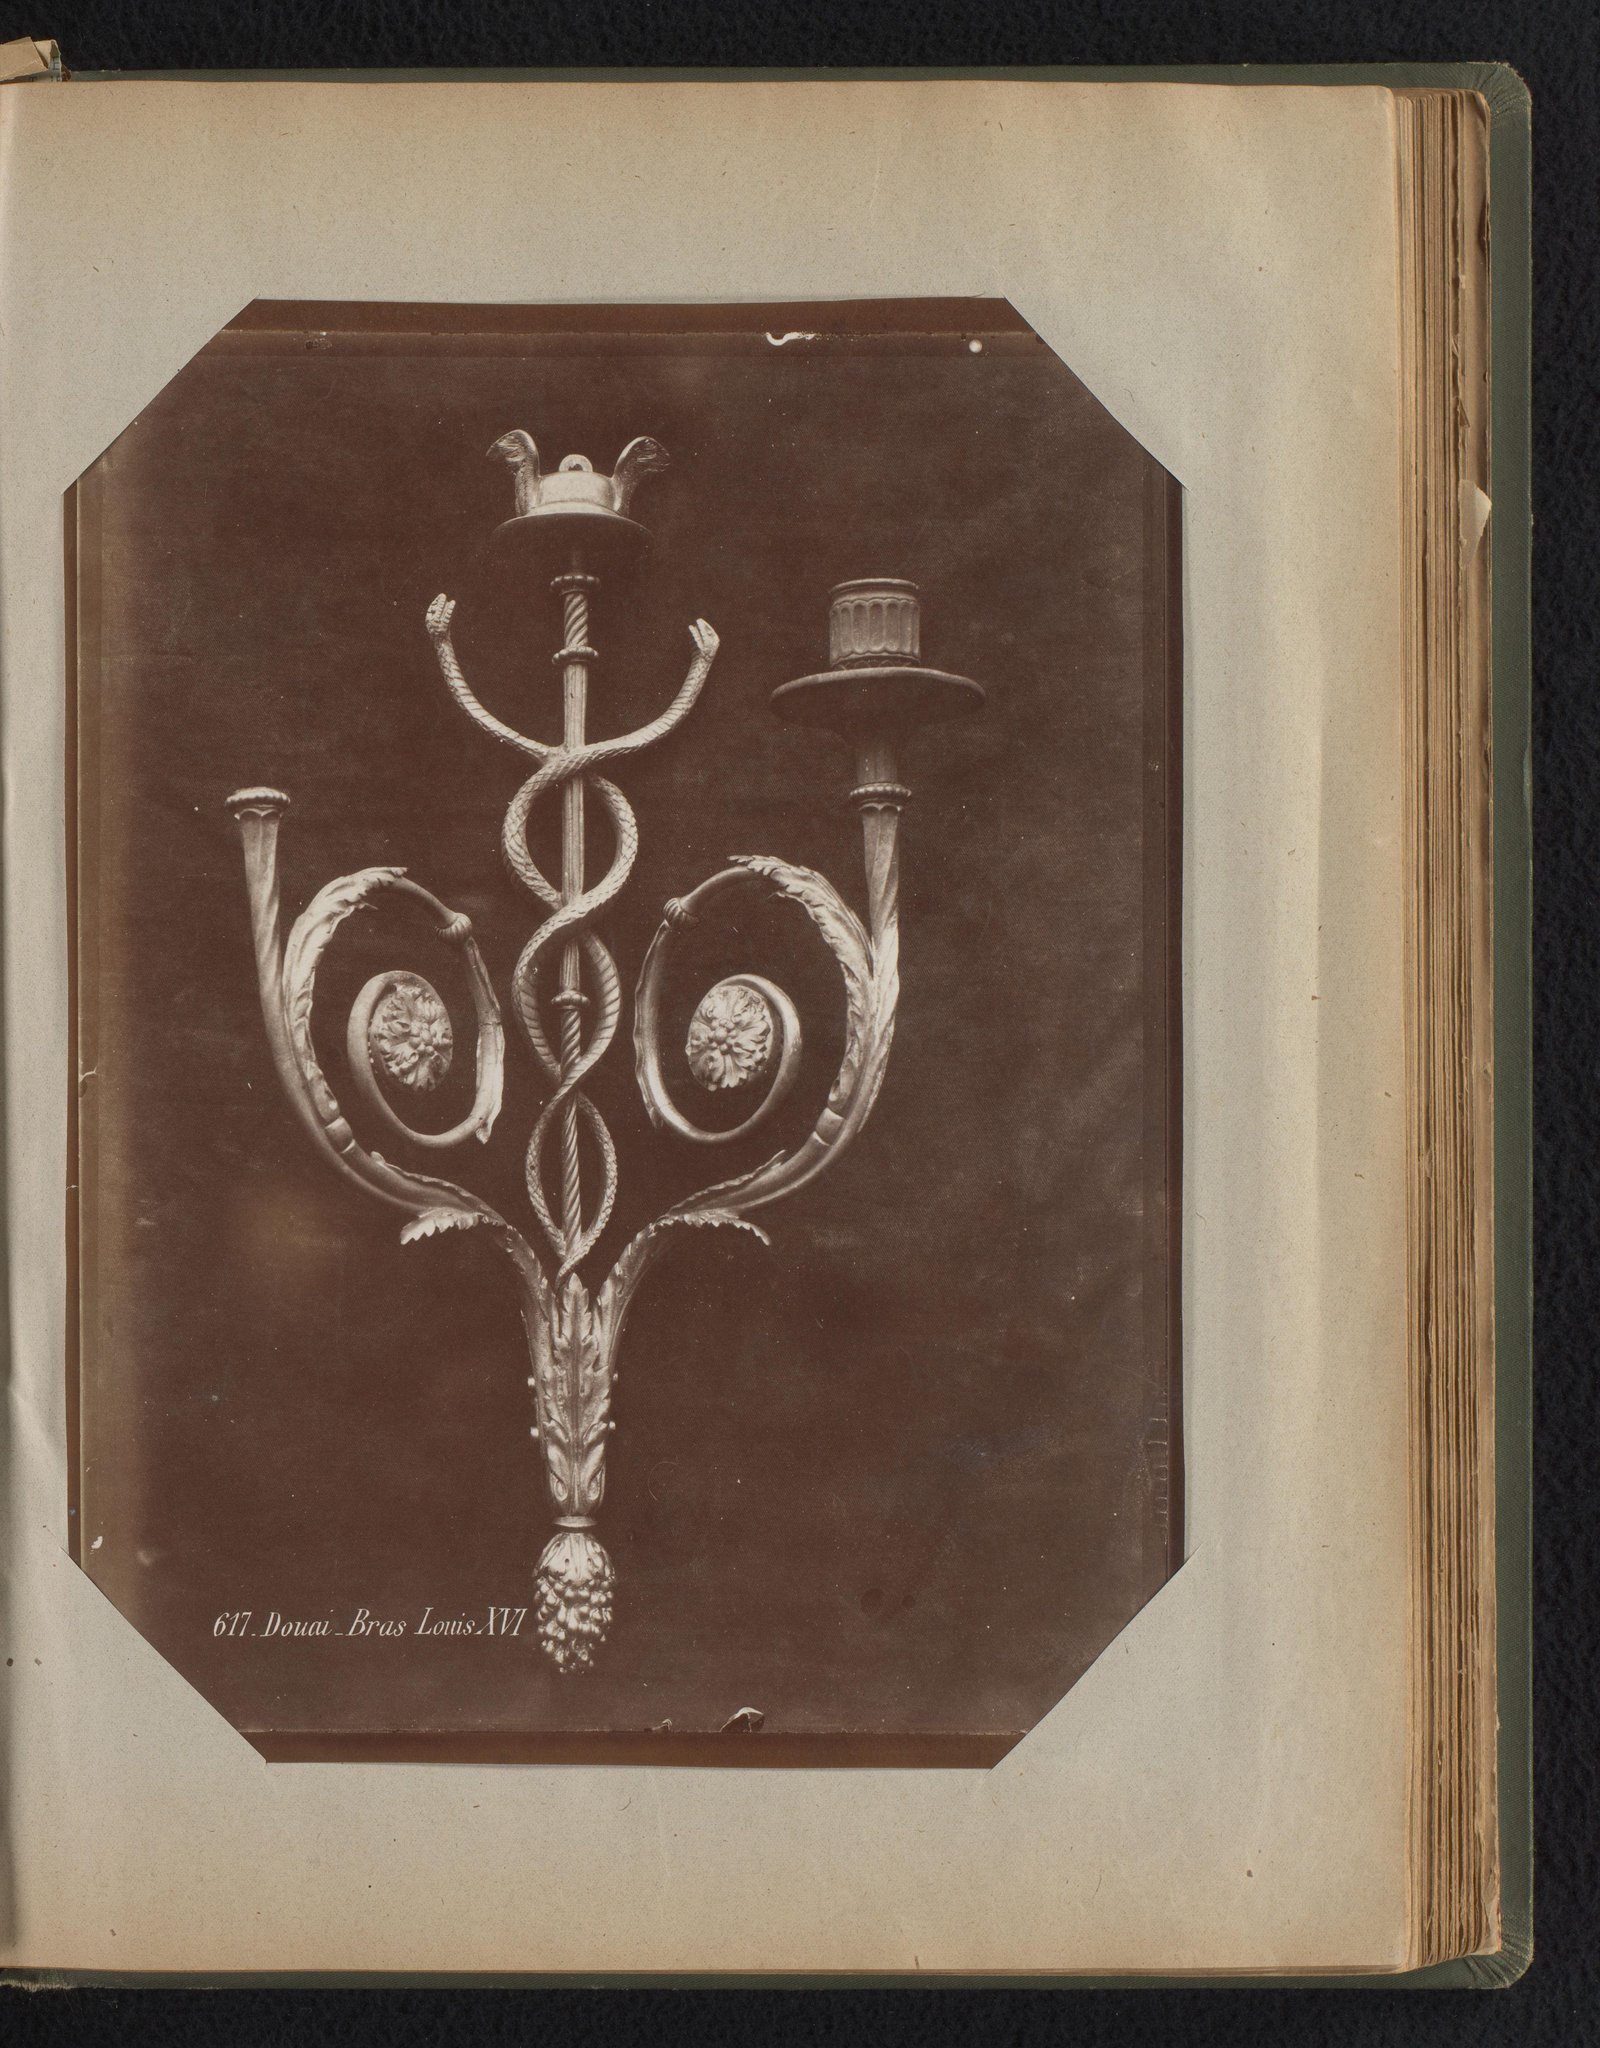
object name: photograph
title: 617. Douai_ Bras Louis XVI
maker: Anonymous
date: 1860-1900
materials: canvas, cardboard, paper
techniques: albumen print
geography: netherlands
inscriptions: annotation: ‘617. Douai_ Bras Louis XVI’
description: Onderdeel van een serie met betrekking tot het interieur van het paleis van Versailles met kroonluchters, deuren, portalen en meubelstukken.